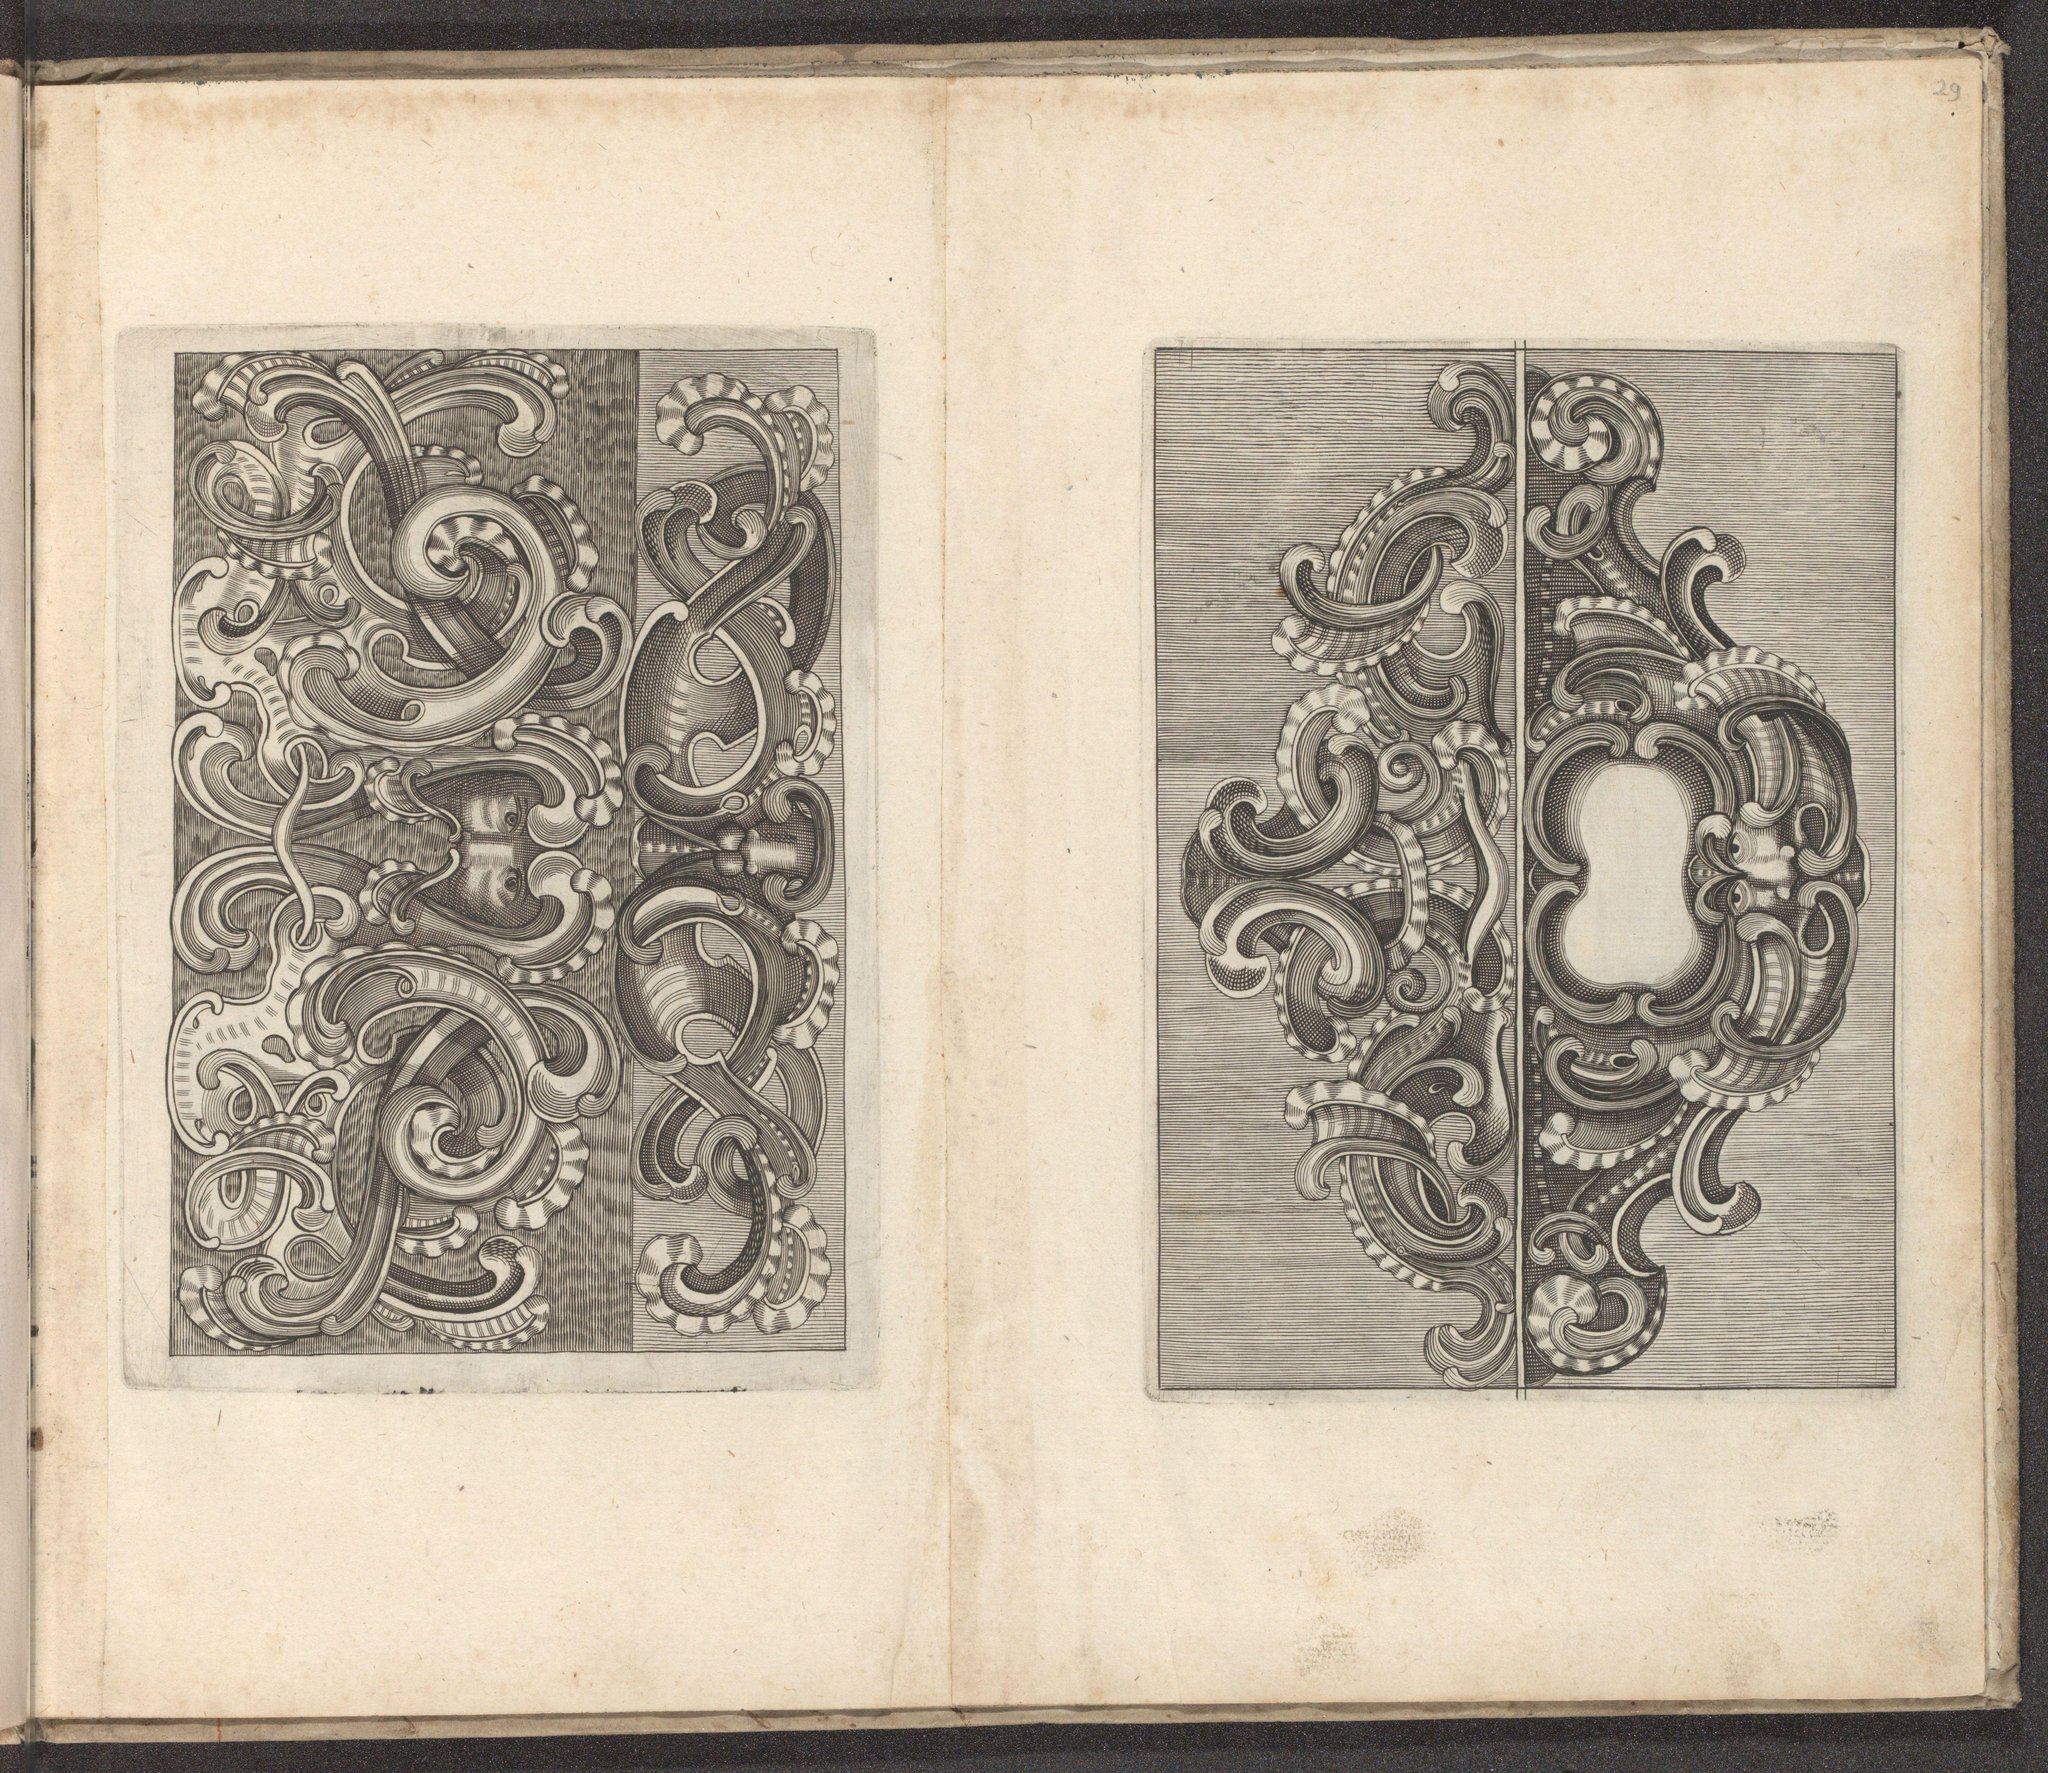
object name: album leaf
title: Vier ornamenten in kwabstijl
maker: Anonymous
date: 1600-1699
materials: paper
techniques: engraving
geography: germany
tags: auricular ornament, lobe style ~ ornament, ornament ~ cartouche, mask, mascaron ~ ornament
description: Twee voorstellingen op een tweedelig albumblad. Beide voorstellingen zijn horizontaal in tweeën gedeeld. In elk deel een ornament in kwabstijl. In twee ornamenten is een masker verwerkt. Het onderste ornament van de rechter voorstelling met cartouche. De prent maakt deel uit van een album.